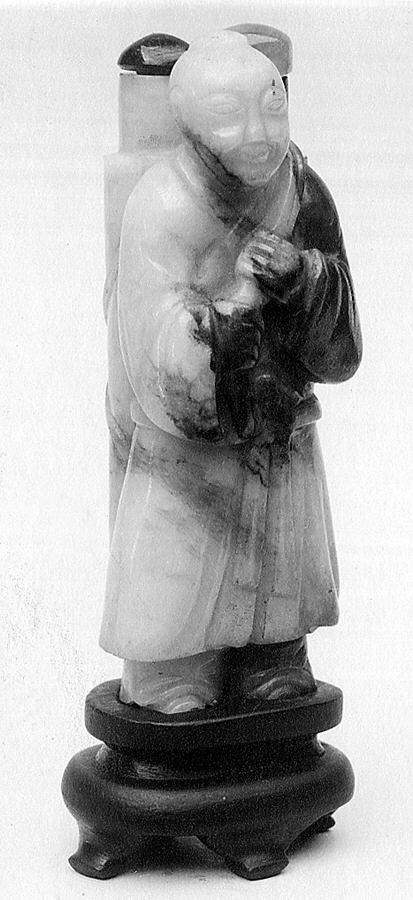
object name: double snuff bottle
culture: chinese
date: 1736-1795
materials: gemstone, glass, jade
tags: men